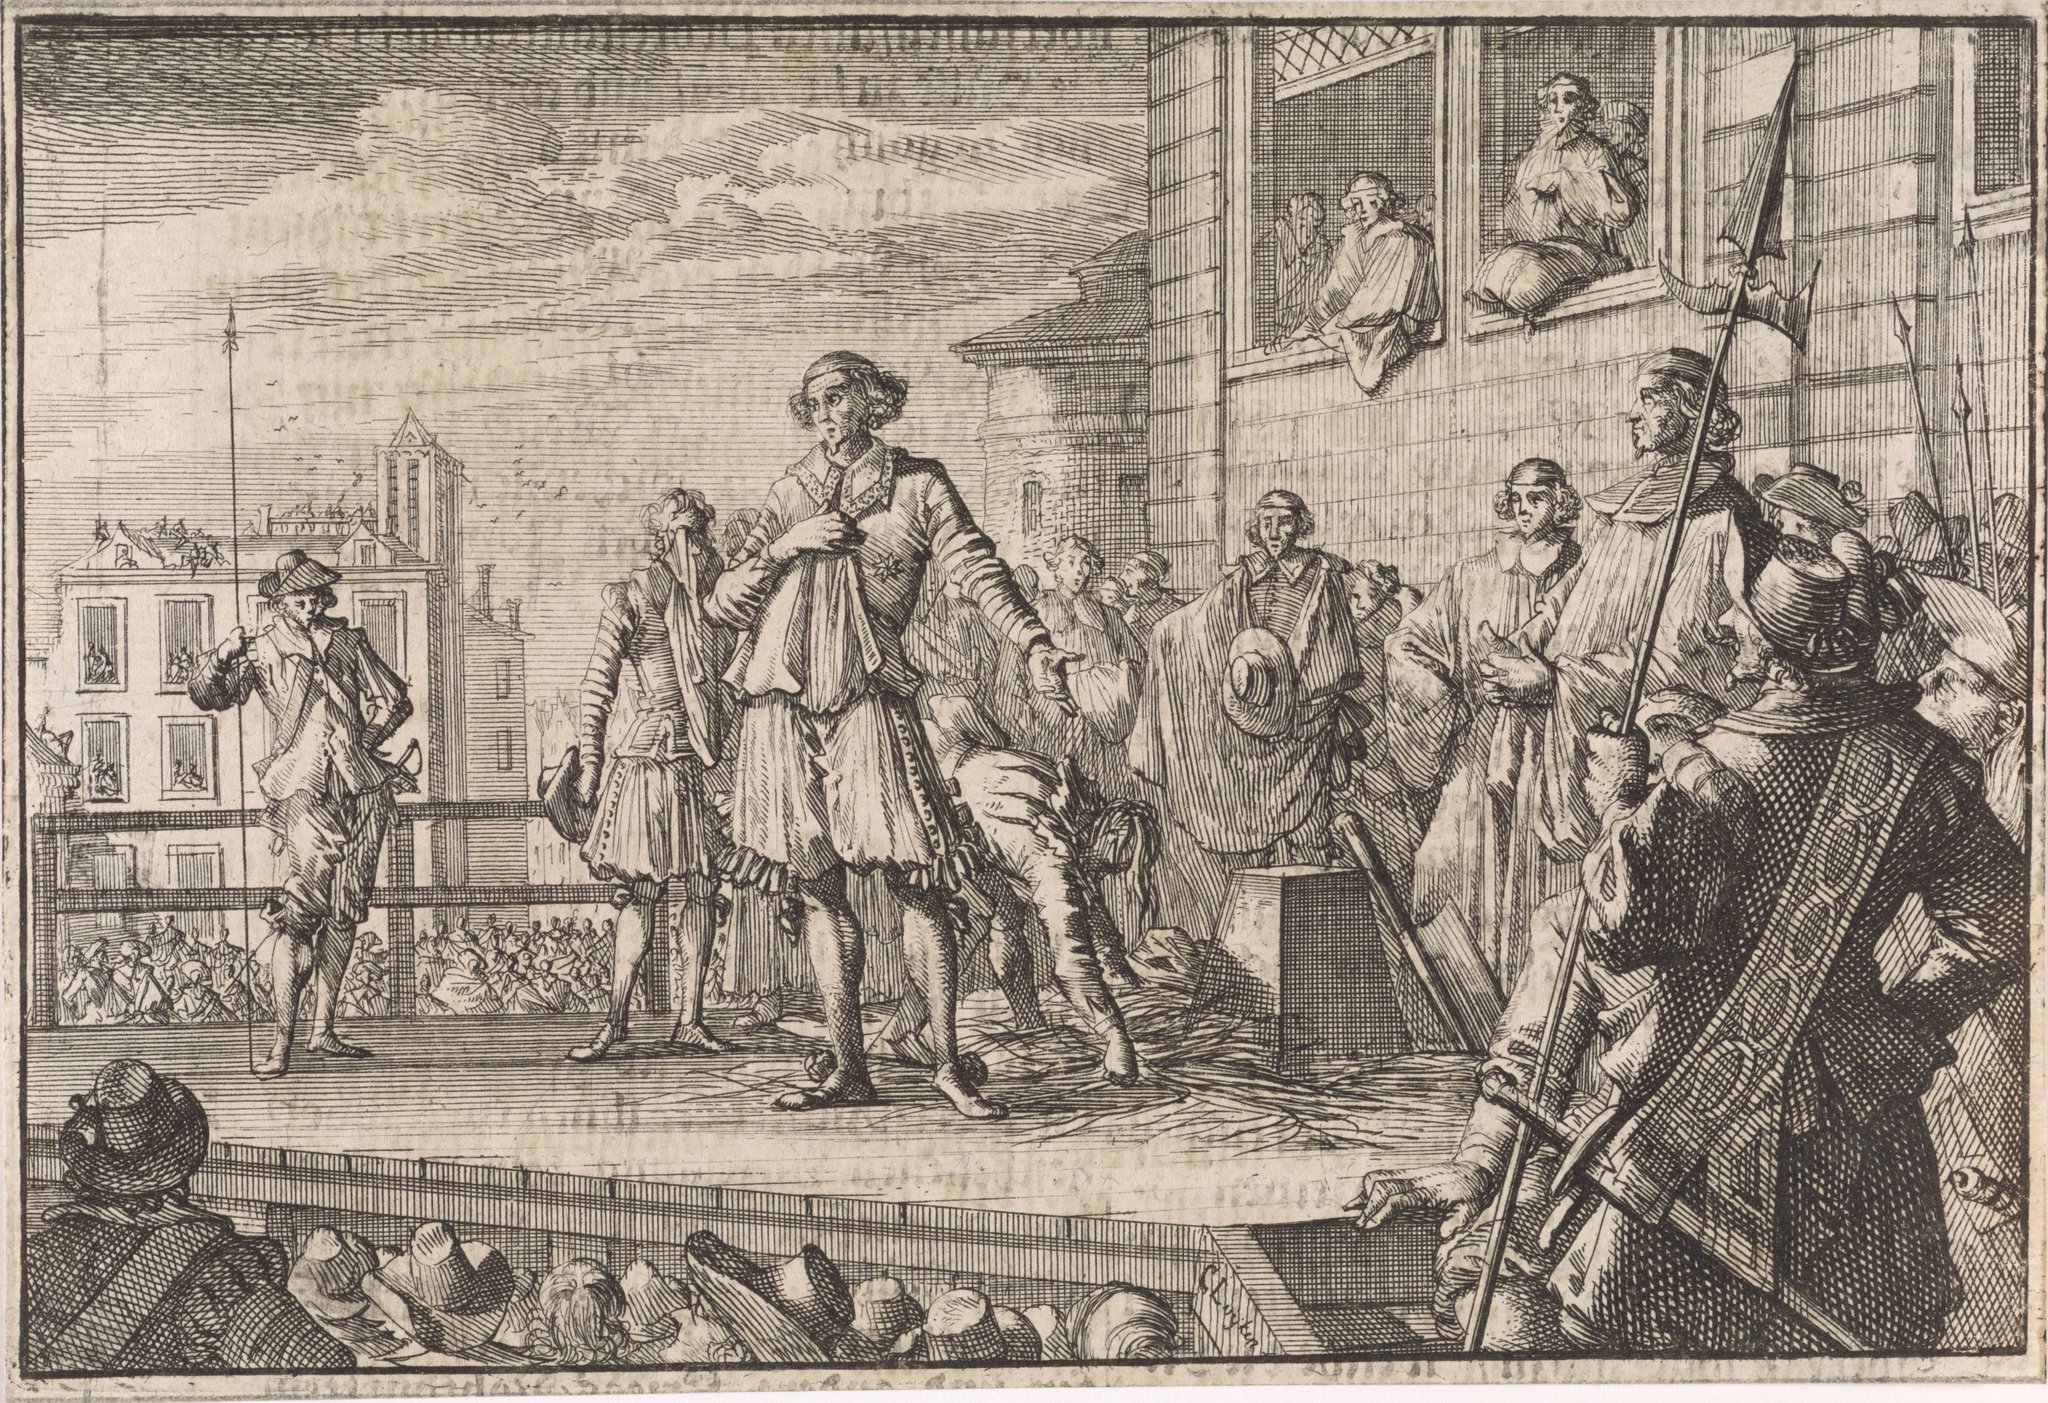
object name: history print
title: Thomas Wentworth, graaf van Strafford spreekt het volk toe vanaf het schavot, 1641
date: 1701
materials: paper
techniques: etching, letterpress printing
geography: frankfurt am main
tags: london, politician, on the scaffold or place of execution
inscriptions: collector's mark: Lugt 2228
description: Boekillustratie voor Hiob Ludolff. Allgemeine Schau-Bühne der Welt. Deel II. Frankfurt am Main: Johann David Zunnern, 1701, p. 905.